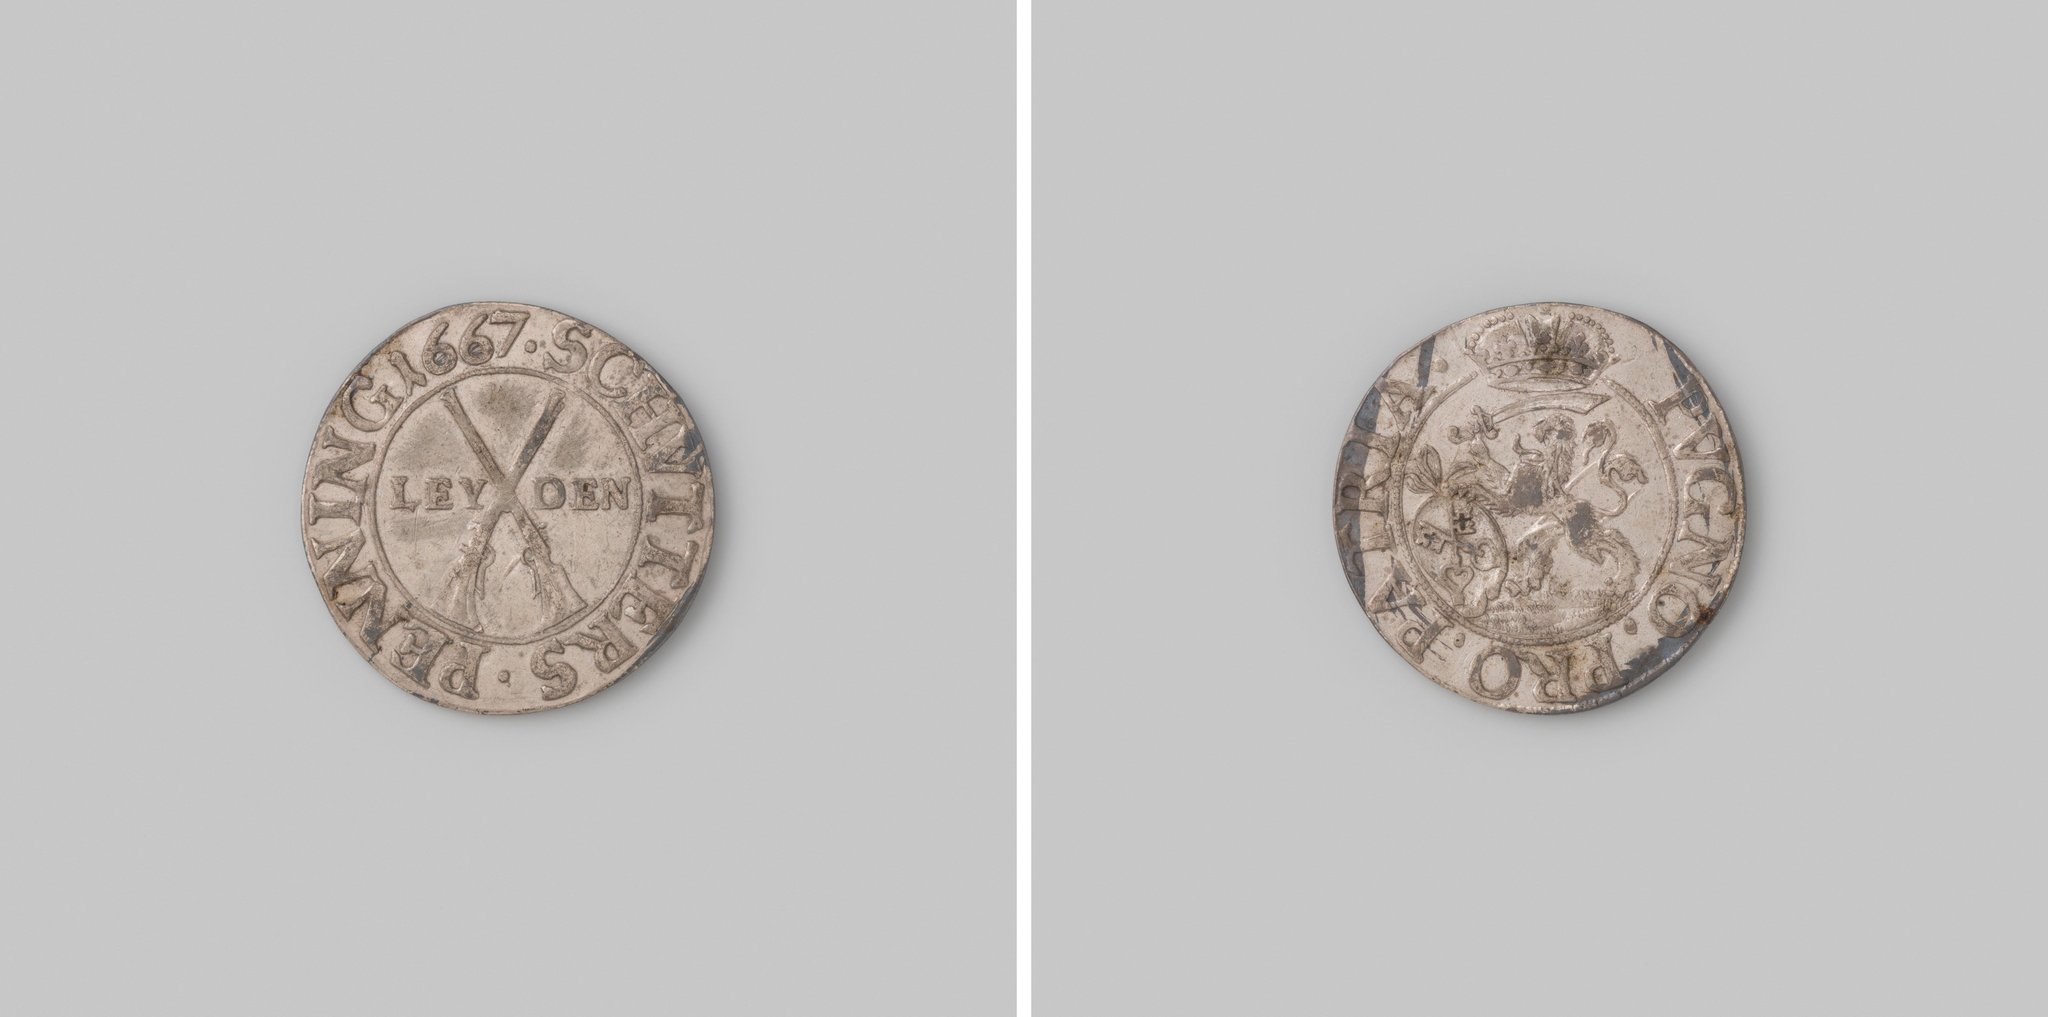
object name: marksman medal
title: Schutterspenning van Leiden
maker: Anonymous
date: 1667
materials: silver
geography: leiden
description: Zilveren schutterspenning van Leiden. Voorzijde: een gekroonde klimmende leeuw met een zwaard in zijn rechter en een schild met het Leidse wapen in zijn linker klauw. Omschrift: PVGNO PRO PATRIA (ik vecht voor het vaderland). Keerzijde: twee gekruiste musketten tussen LEY en DEN. Omschrift: SCHVTTERS PENNING en daarachter het jaartal.